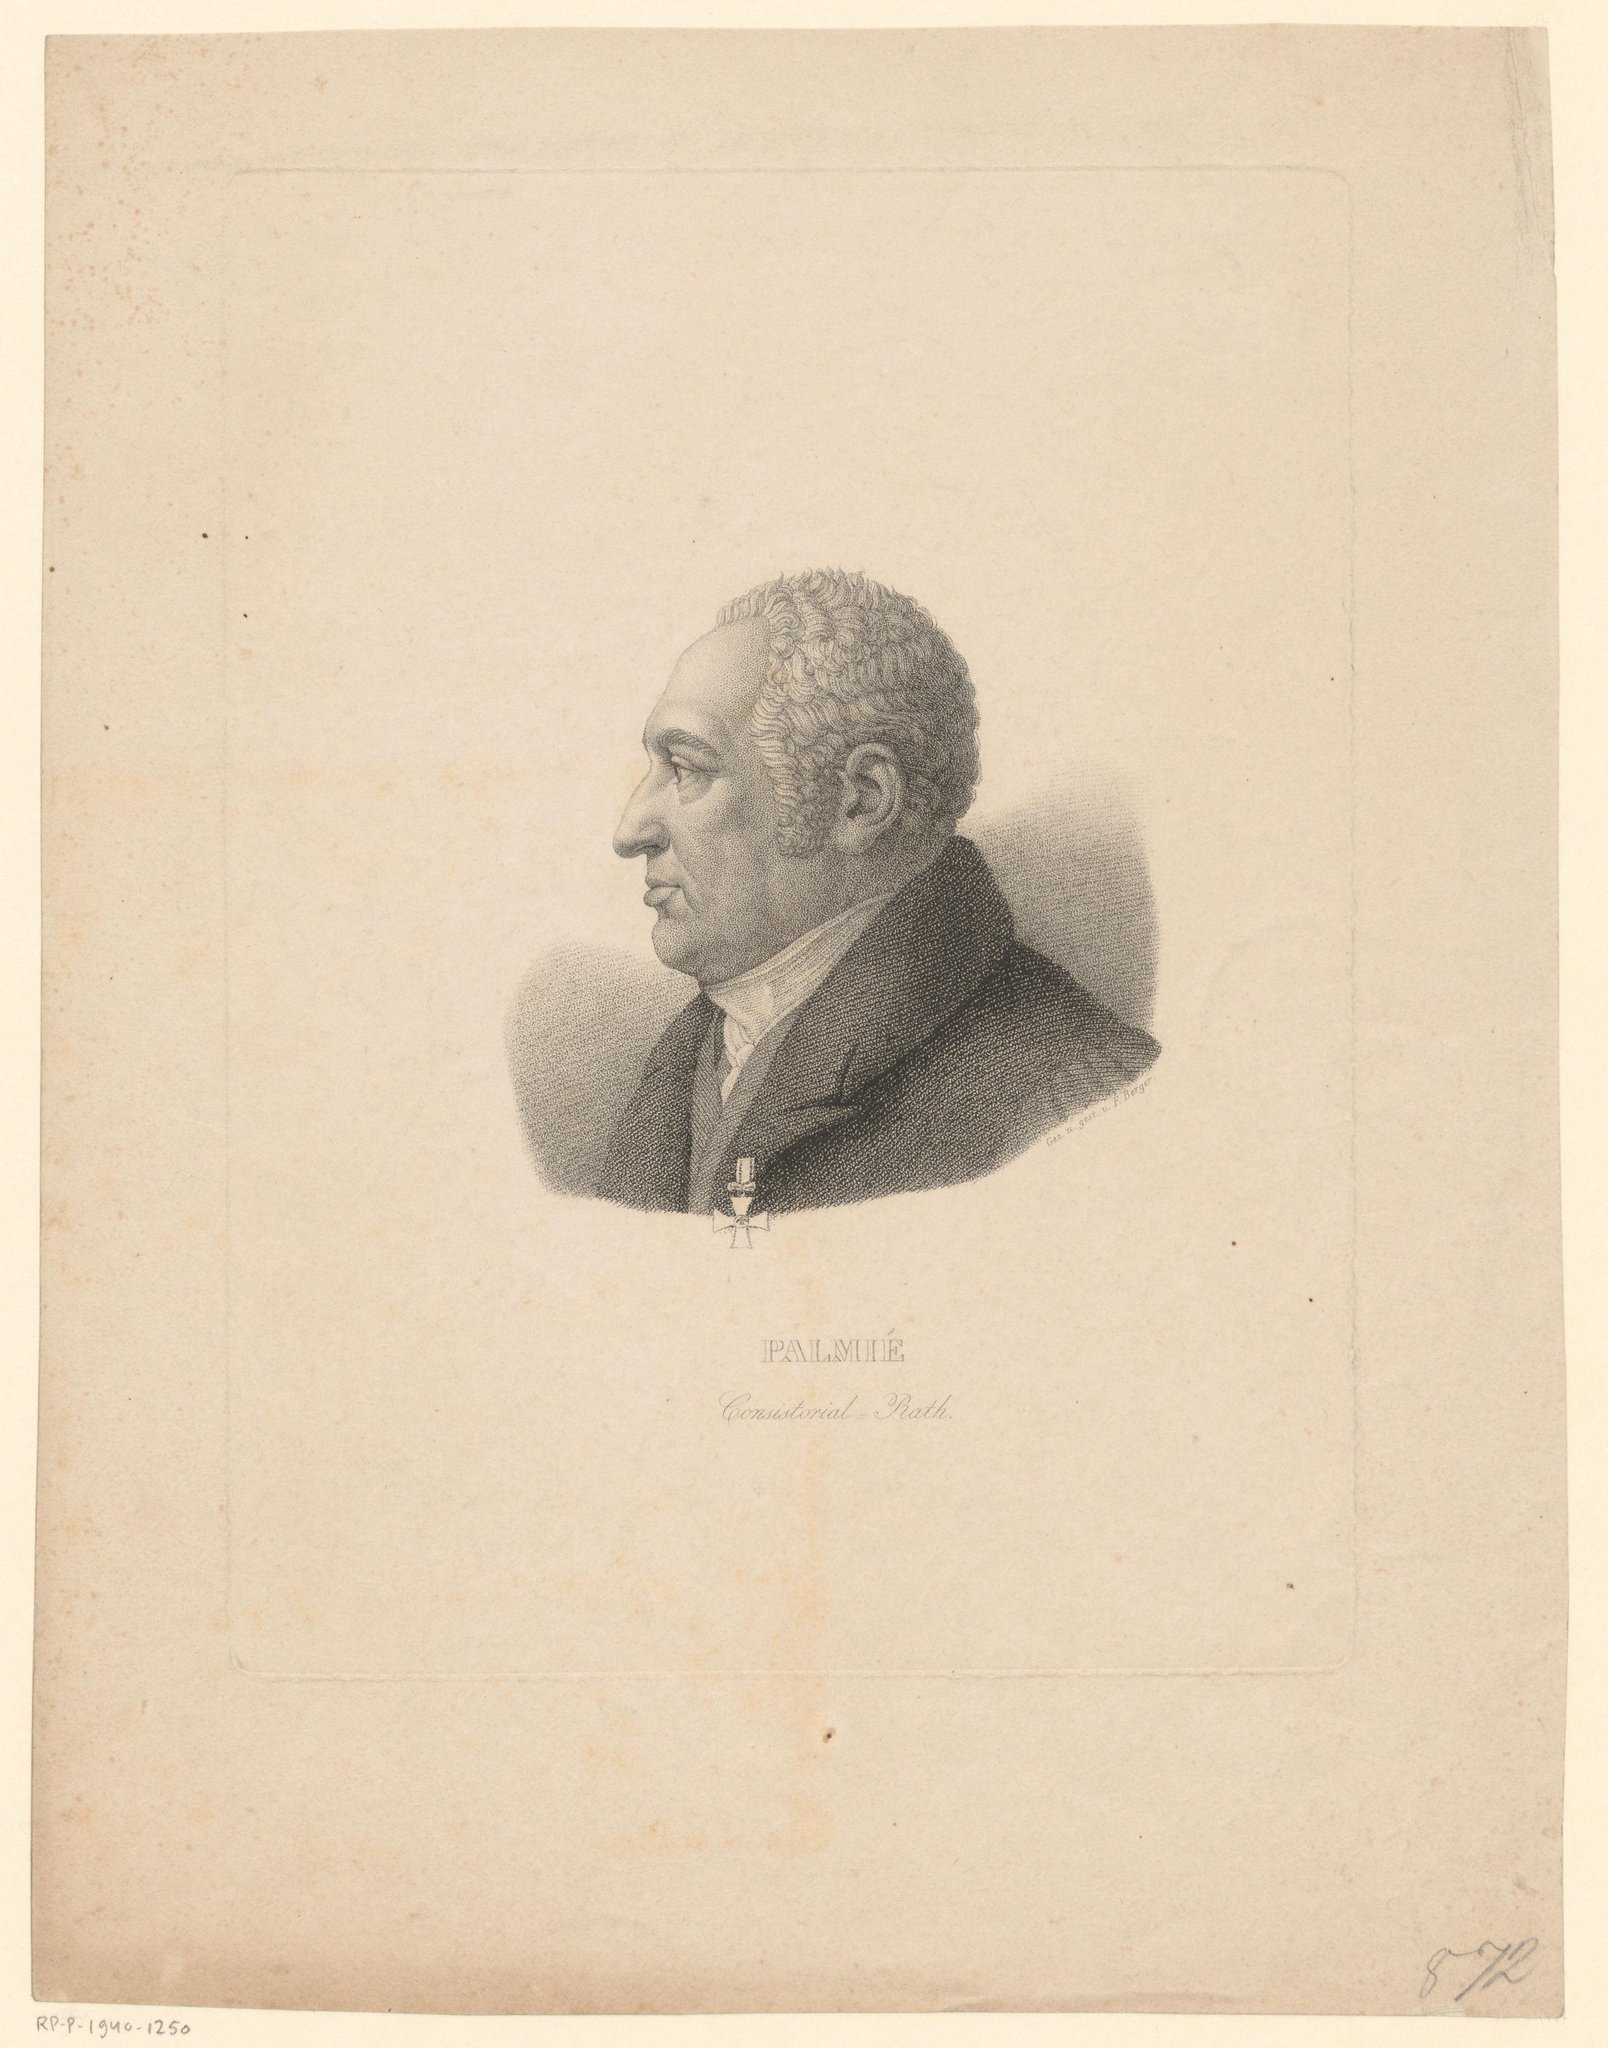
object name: print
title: Portret van Jean Michel Palmié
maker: ferdinand berger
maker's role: print maker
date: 1793-1844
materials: paper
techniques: etching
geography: berlin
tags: berlin, historical persons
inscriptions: collector's mark: Lugt 2228